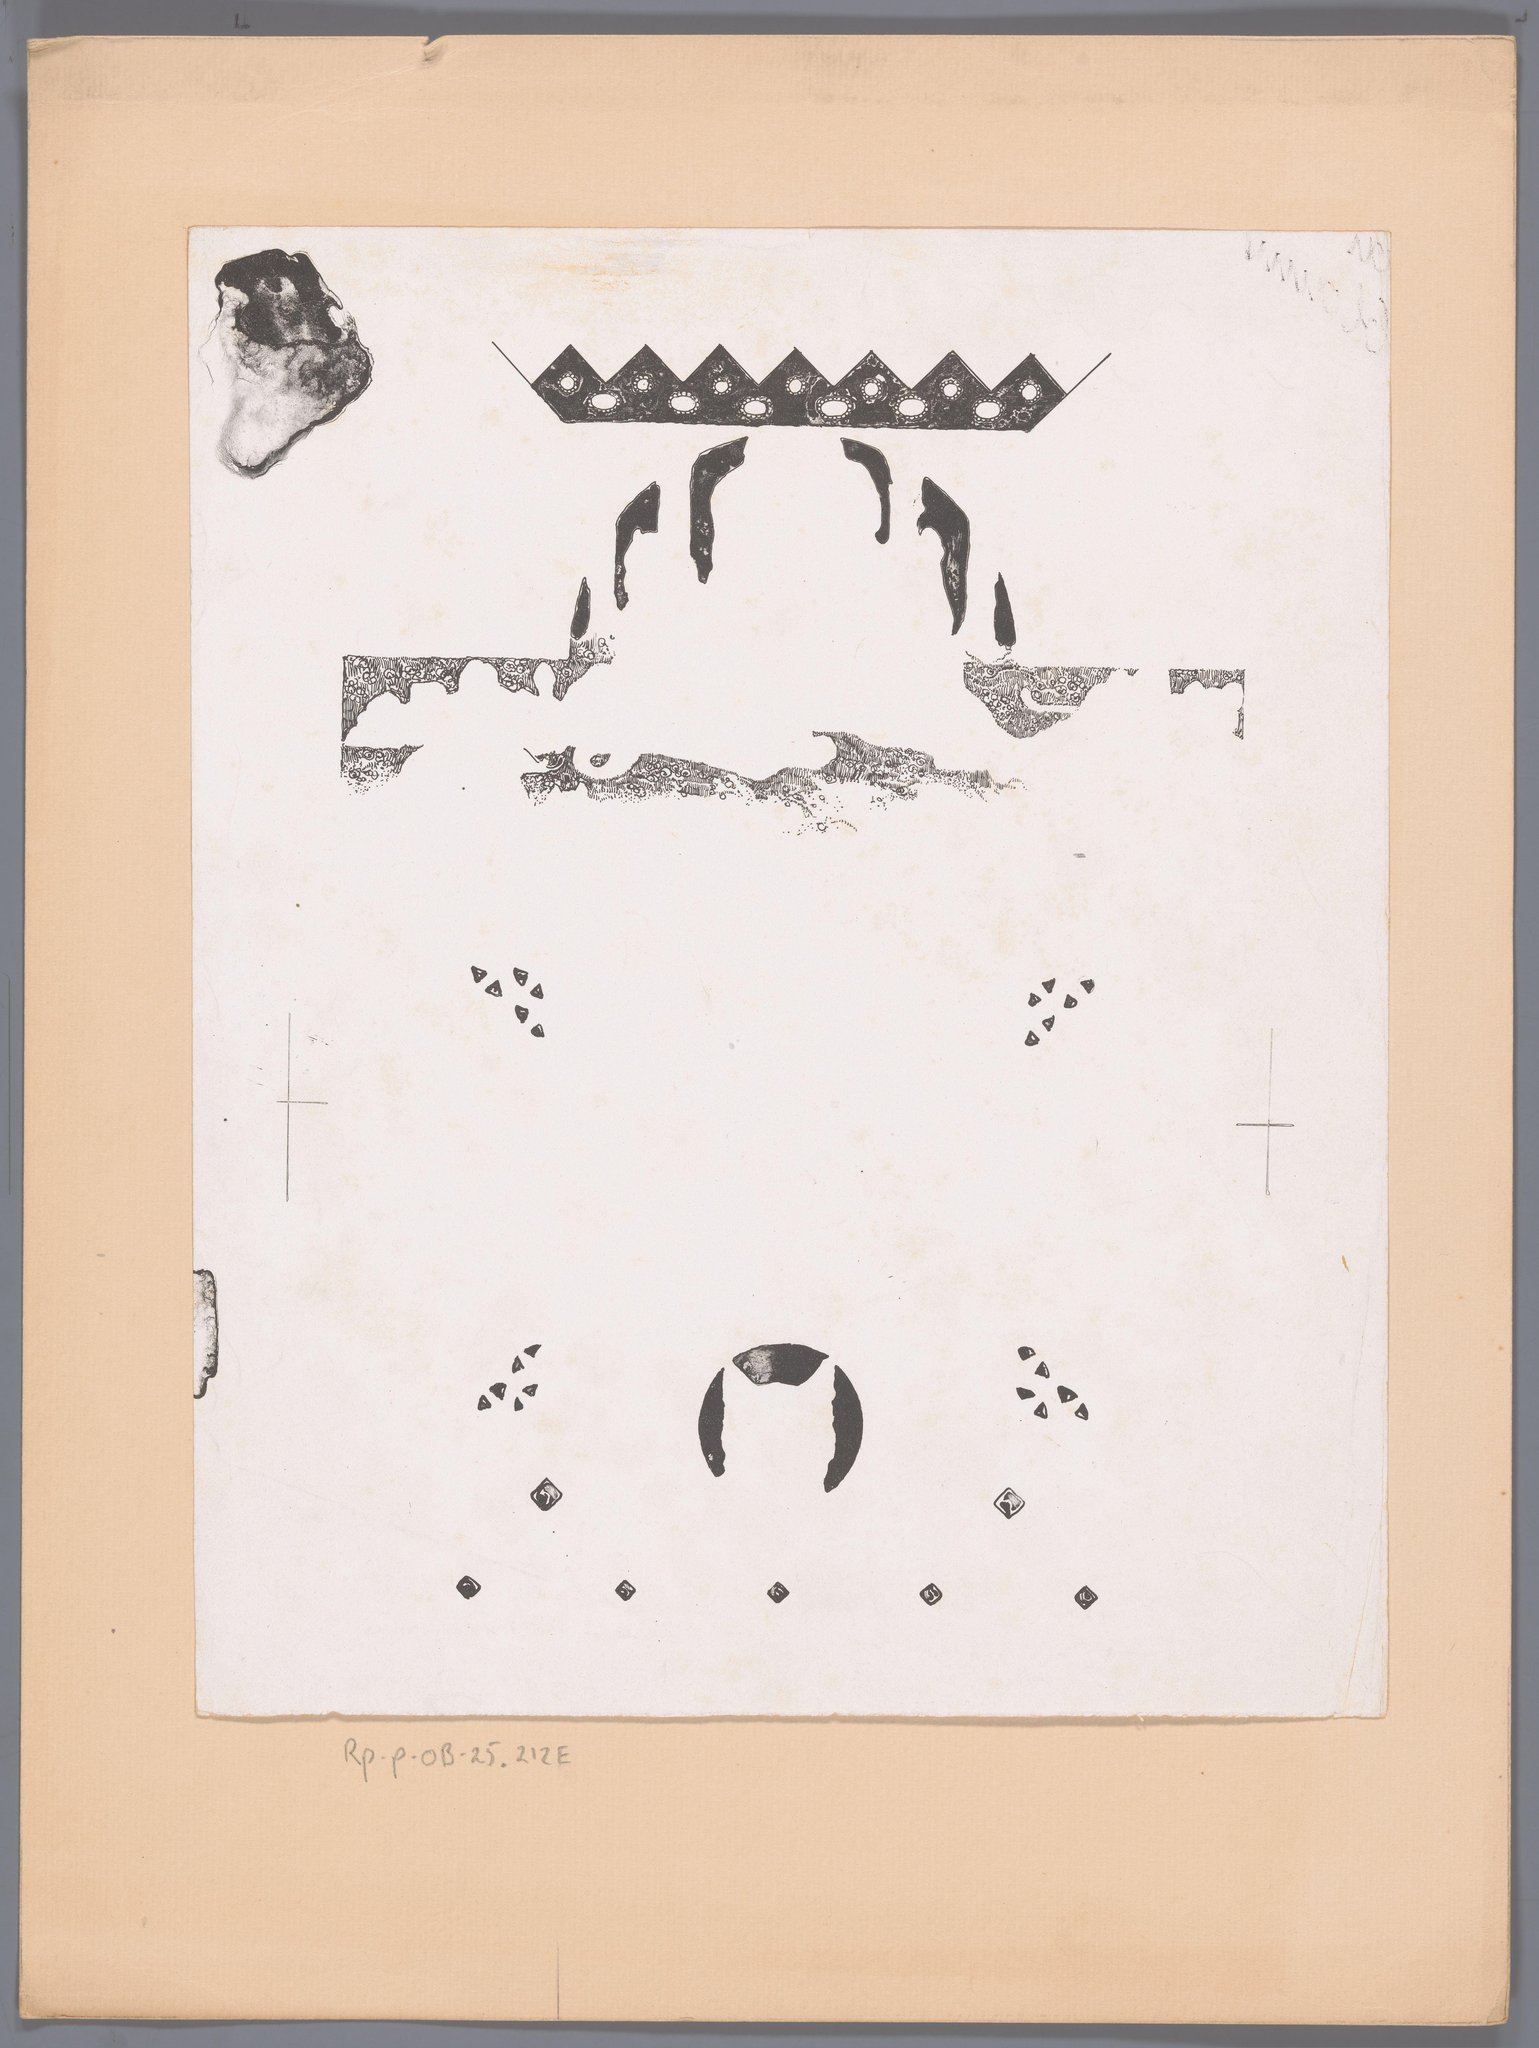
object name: design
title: Ontwerp voor titelpagina voor: Stijn Streuvels, Reinaert de Vos, 1910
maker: bernard willem wierink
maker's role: draughtsman, print maker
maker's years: 1856-1939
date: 1910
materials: paper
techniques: lithograph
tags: fable of reynard the fox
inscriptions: collector's mark: Lugt 2228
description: Niet gebruikt ontwerp voor: Streuvels, Stijn (Frank Lateur). Reinaert de Vos naar verschillende uitgaven van het middeleeuwsche epos. Amsterdam: L.J. Veen, 1910.